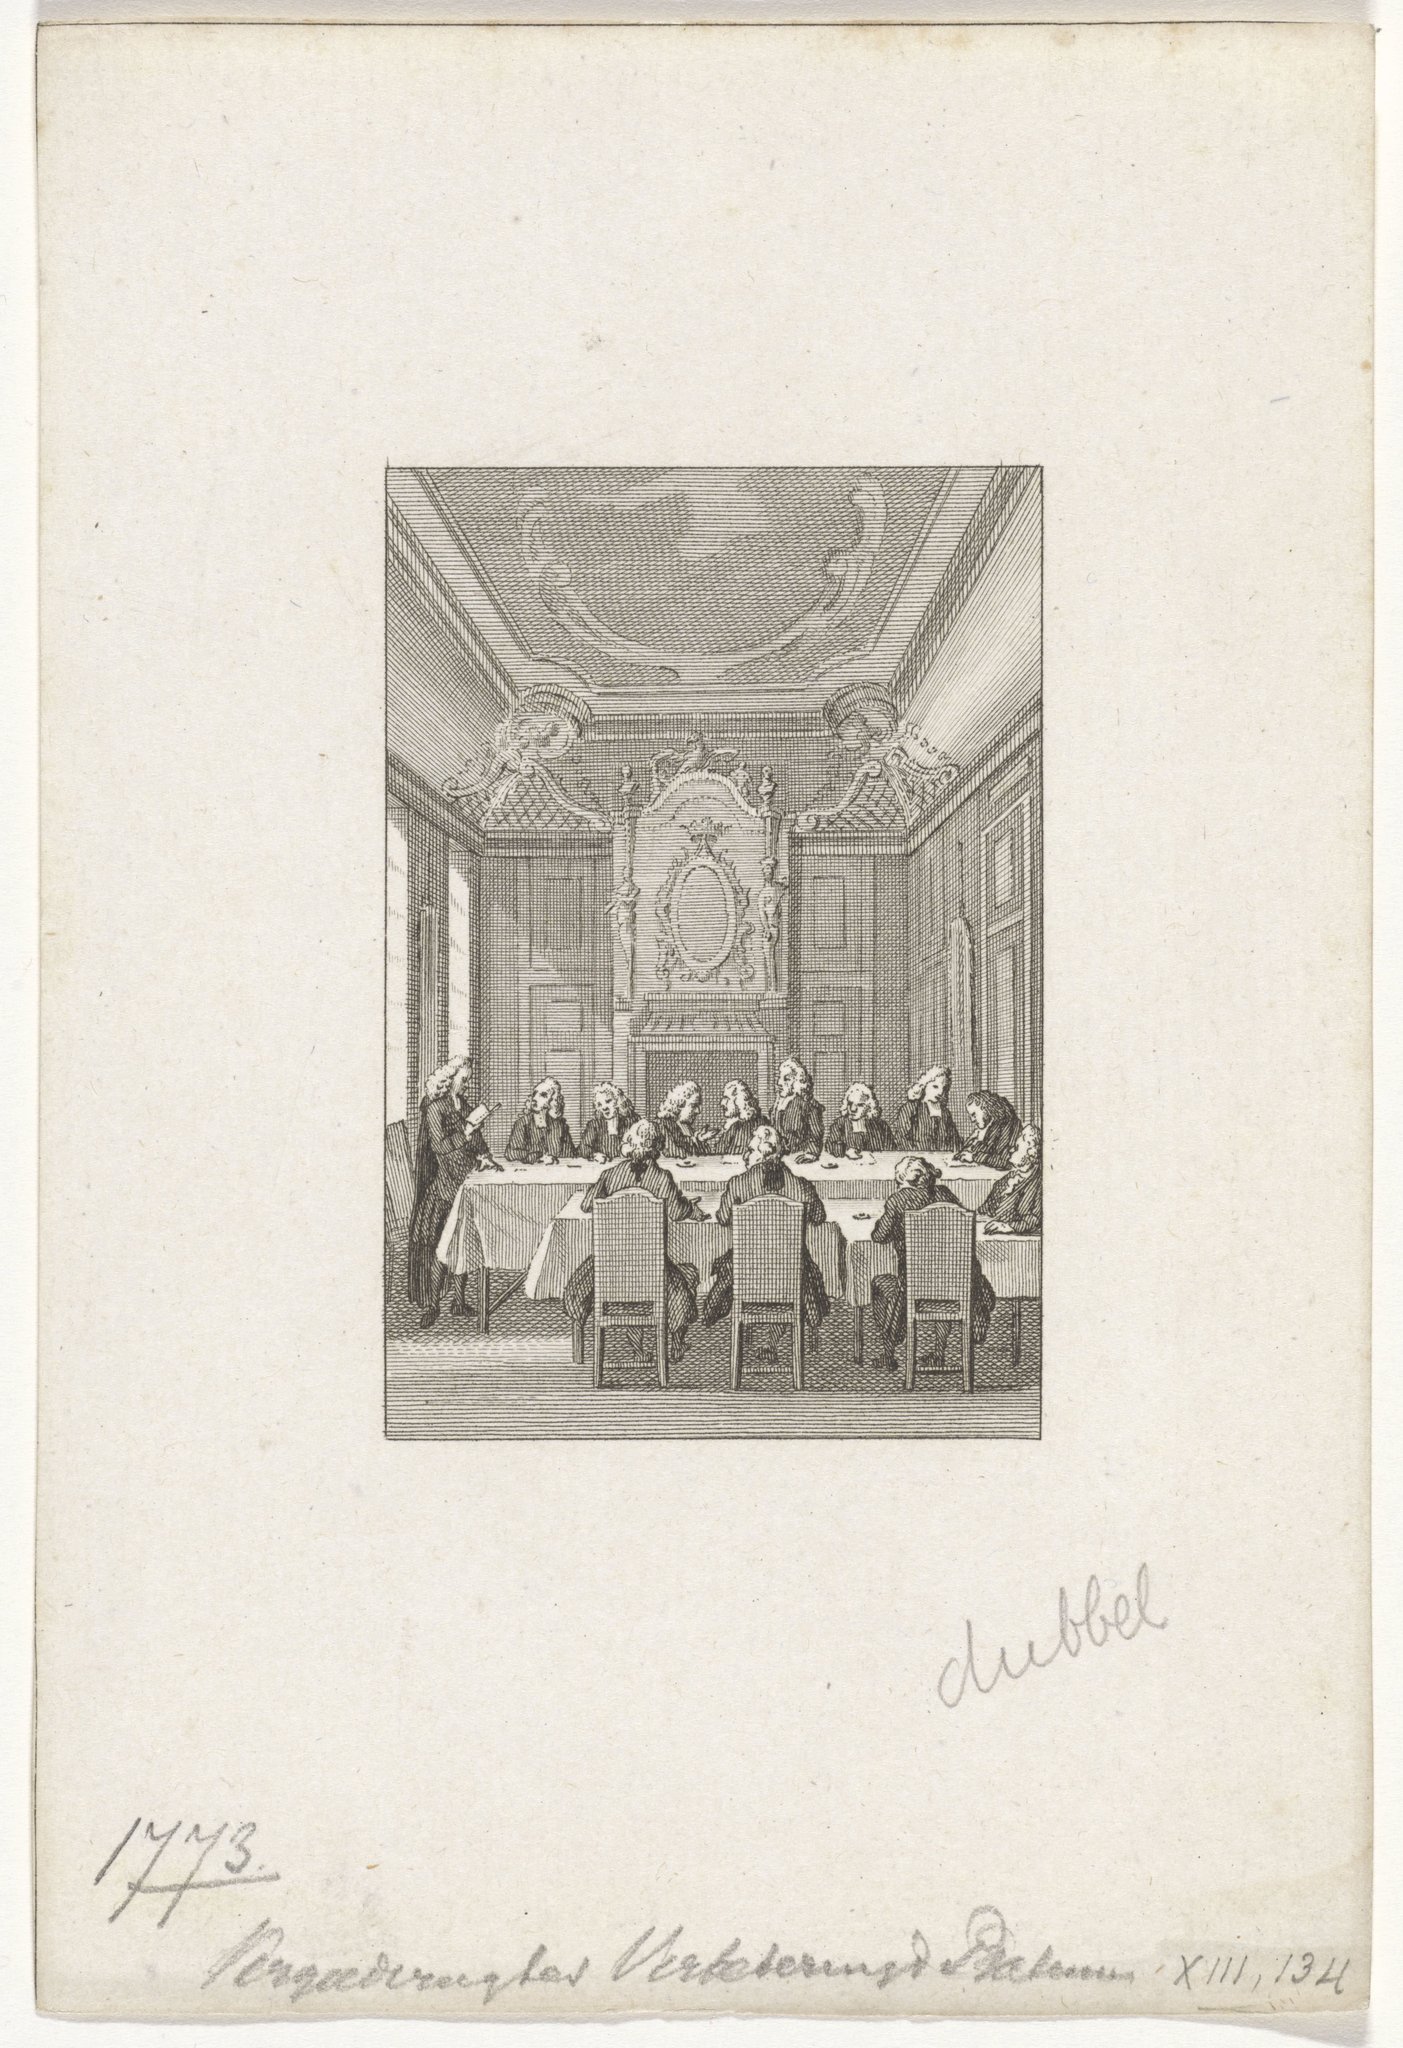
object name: print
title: Openbare voorlezing van enige Psalmen in de nieuwe berijming, 1773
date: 1783-1795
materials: paper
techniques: etching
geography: amsterdam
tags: mauritshuis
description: Openbare voorlezing van enige Psalmen in de nieuwe berijming door de Commissie ter Verbetering van de Rijmpsalmen, in de vergaderzaal in het Mauritshuis op 1 oktober 1773.